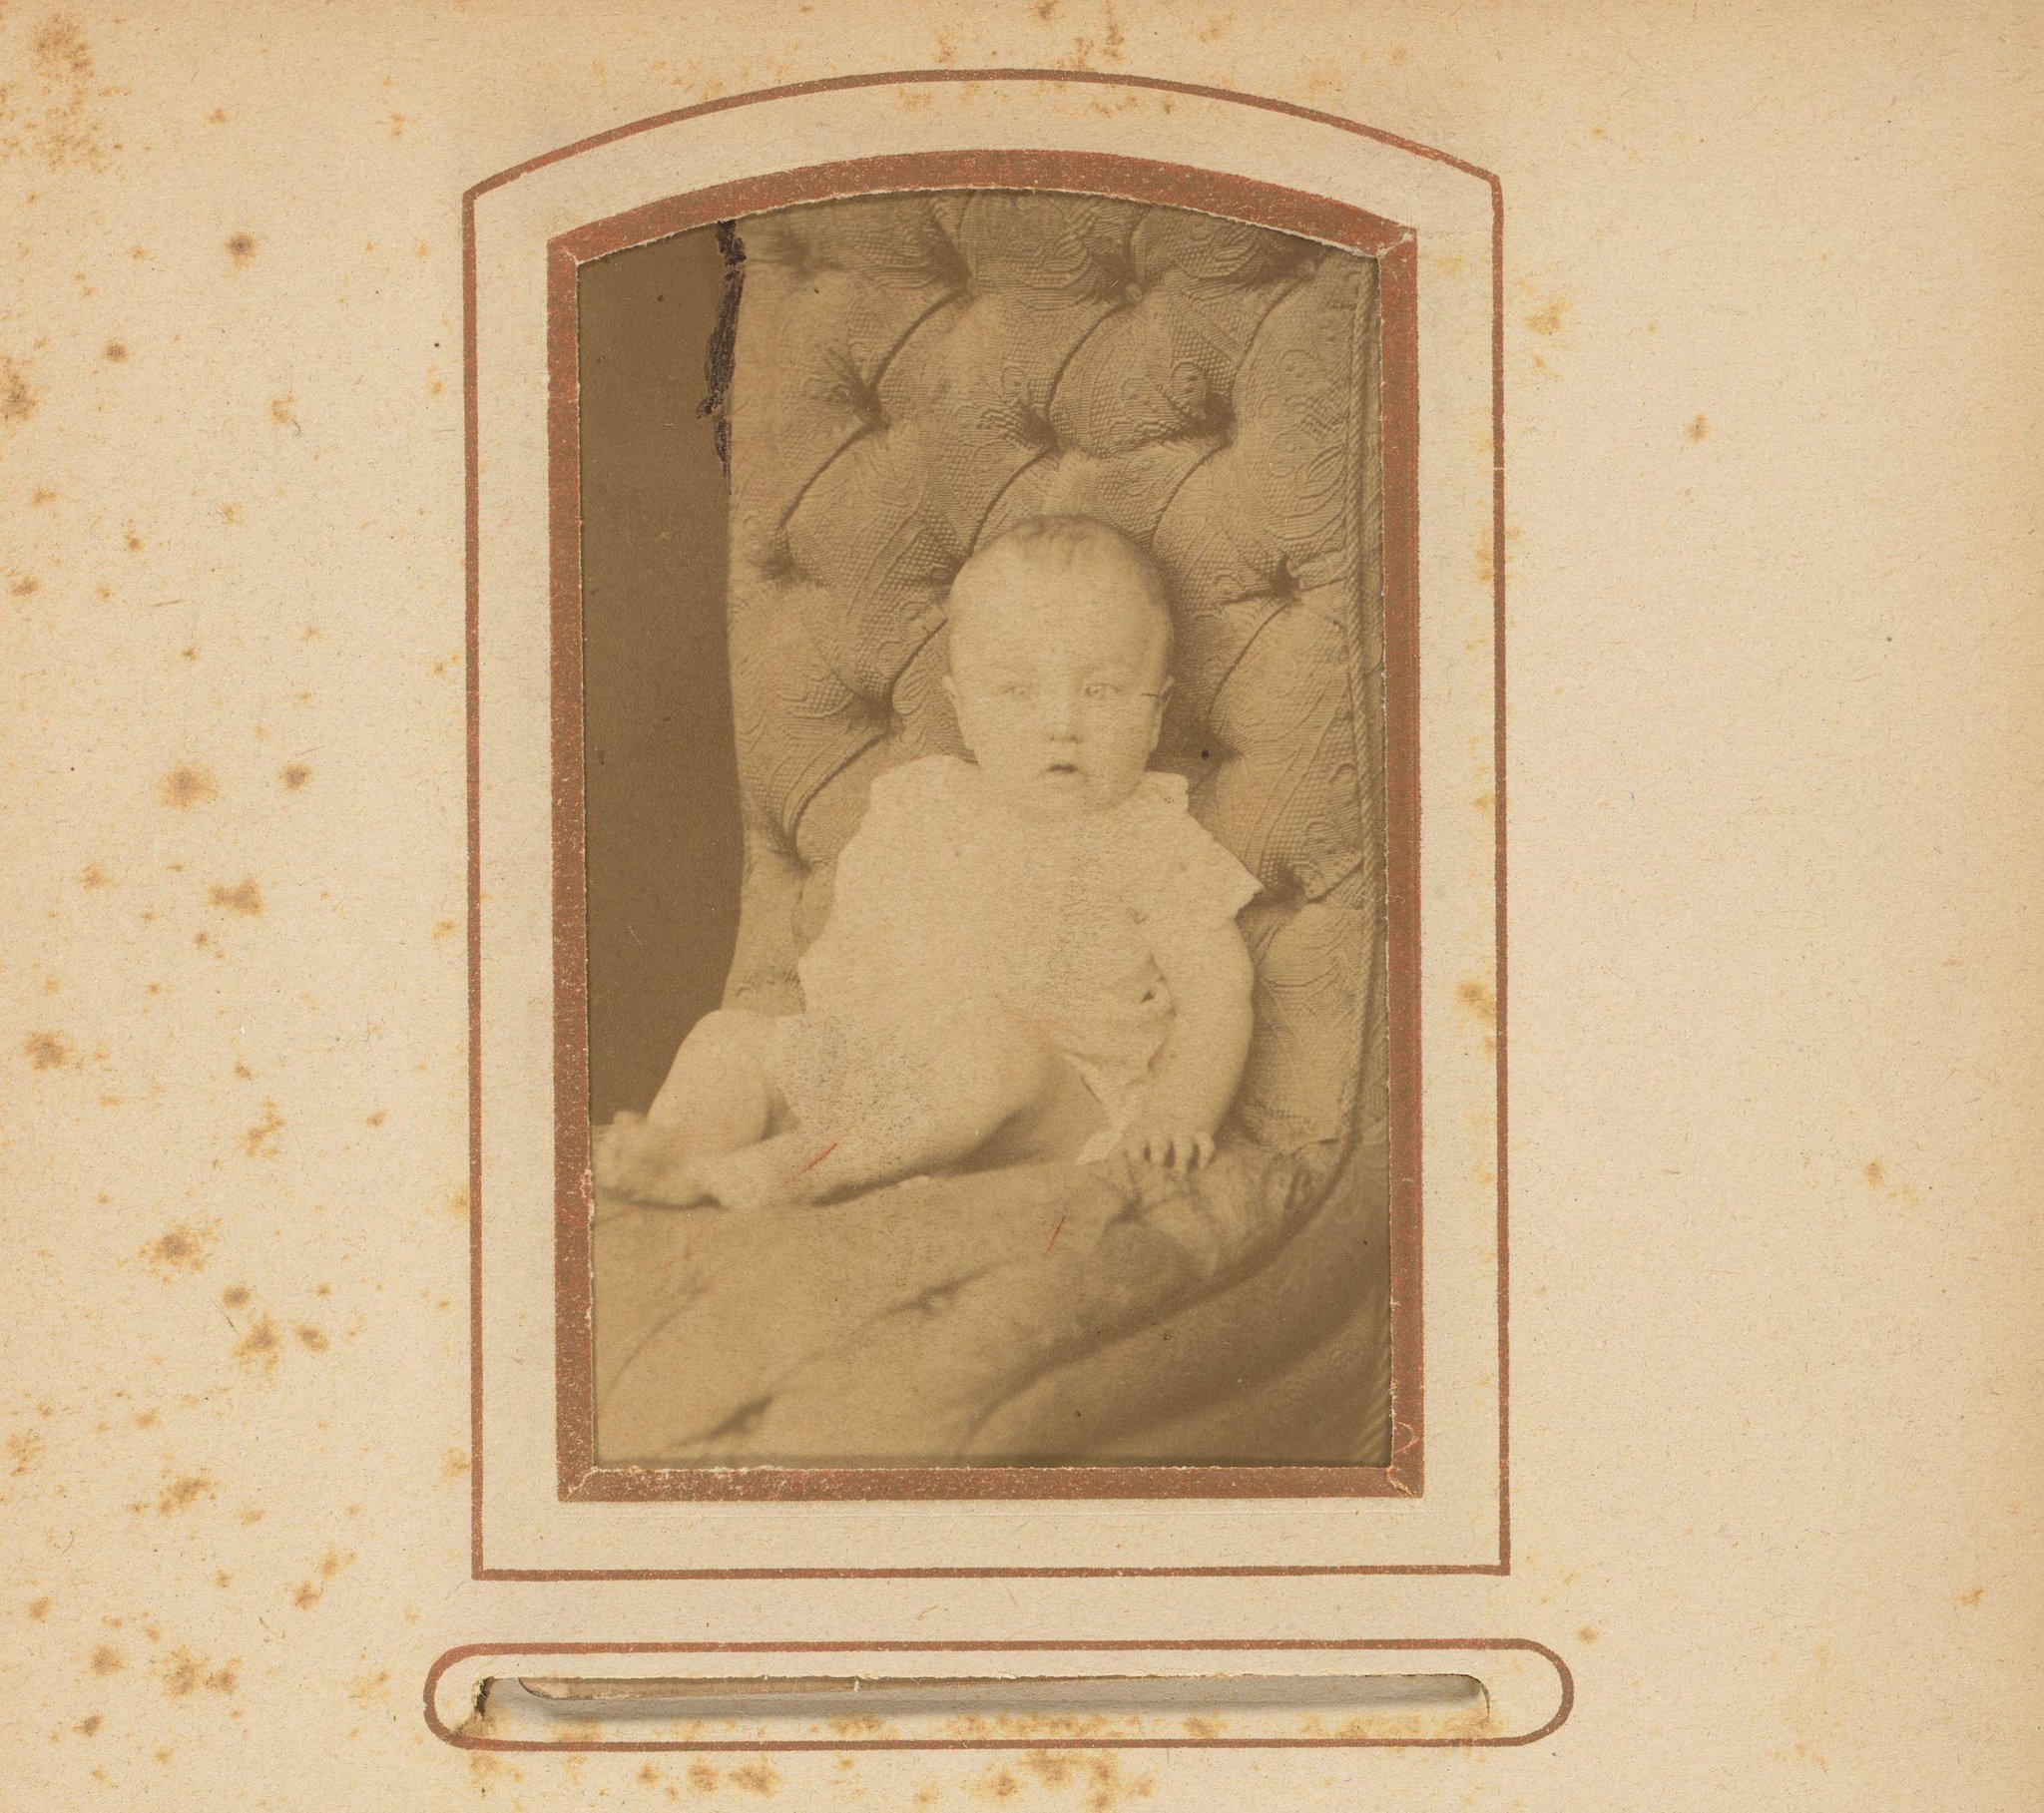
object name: photograph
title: Portret van een kind, zittend op een stoel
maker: johannes hendrikus kramer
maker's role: fotograaf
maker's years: 1846-1901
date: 1885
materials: cardboard, photographic support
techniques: albumen print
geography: utrecht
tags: child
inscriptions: inscription: ‘J.H. Kramer/ Mariaplaats naast de Societeit de Vereeniging/ Utrecht’, annotation: ‘10 Sept, gedaan 1885’